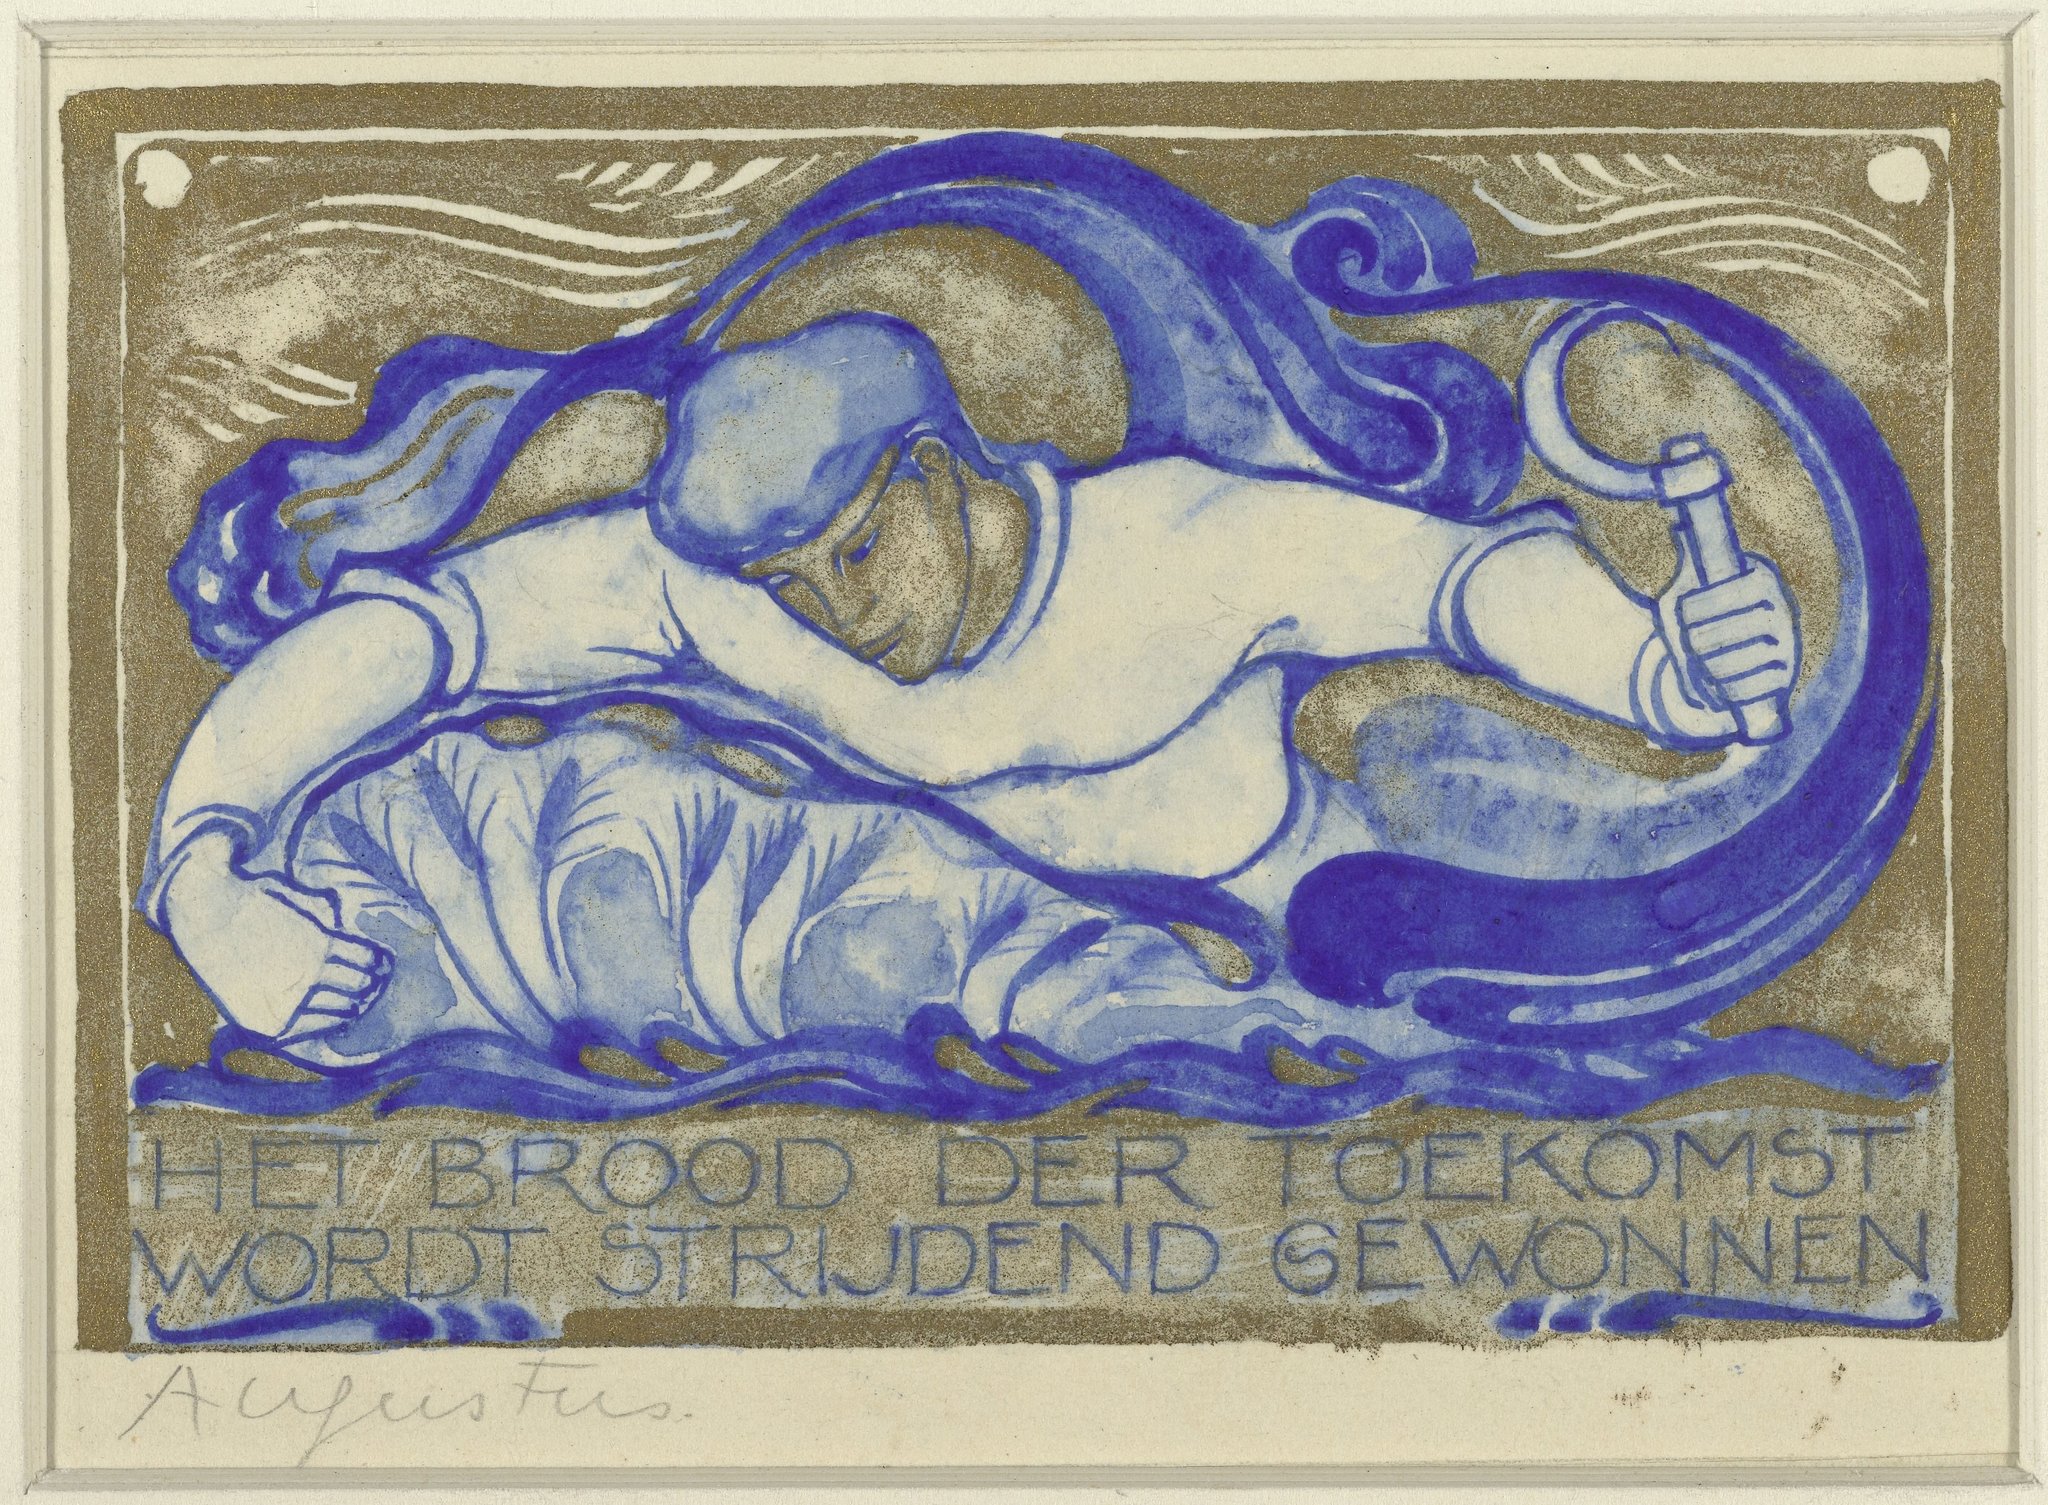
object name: design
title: Het brood der toekomst wordt strijdend gewonnen, augustus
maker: willem arondéus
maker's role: draughtsman, print maker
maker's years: 1894-1943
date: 1929-1930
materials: paint, paper, watercolor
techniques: brush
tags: august; 'agosto' (ripa)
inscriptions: inscription: ‘Augustus’, inscription: ‘HET BROOD DER TOEKOMST WORDT STRIJDEND GEWONNEN’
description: Man ten halven lijve met een sikkel in zijn hand, met onder zijn arm een aantal granen, tegen een goudkleurige achtergrond met blauw-witte banen.